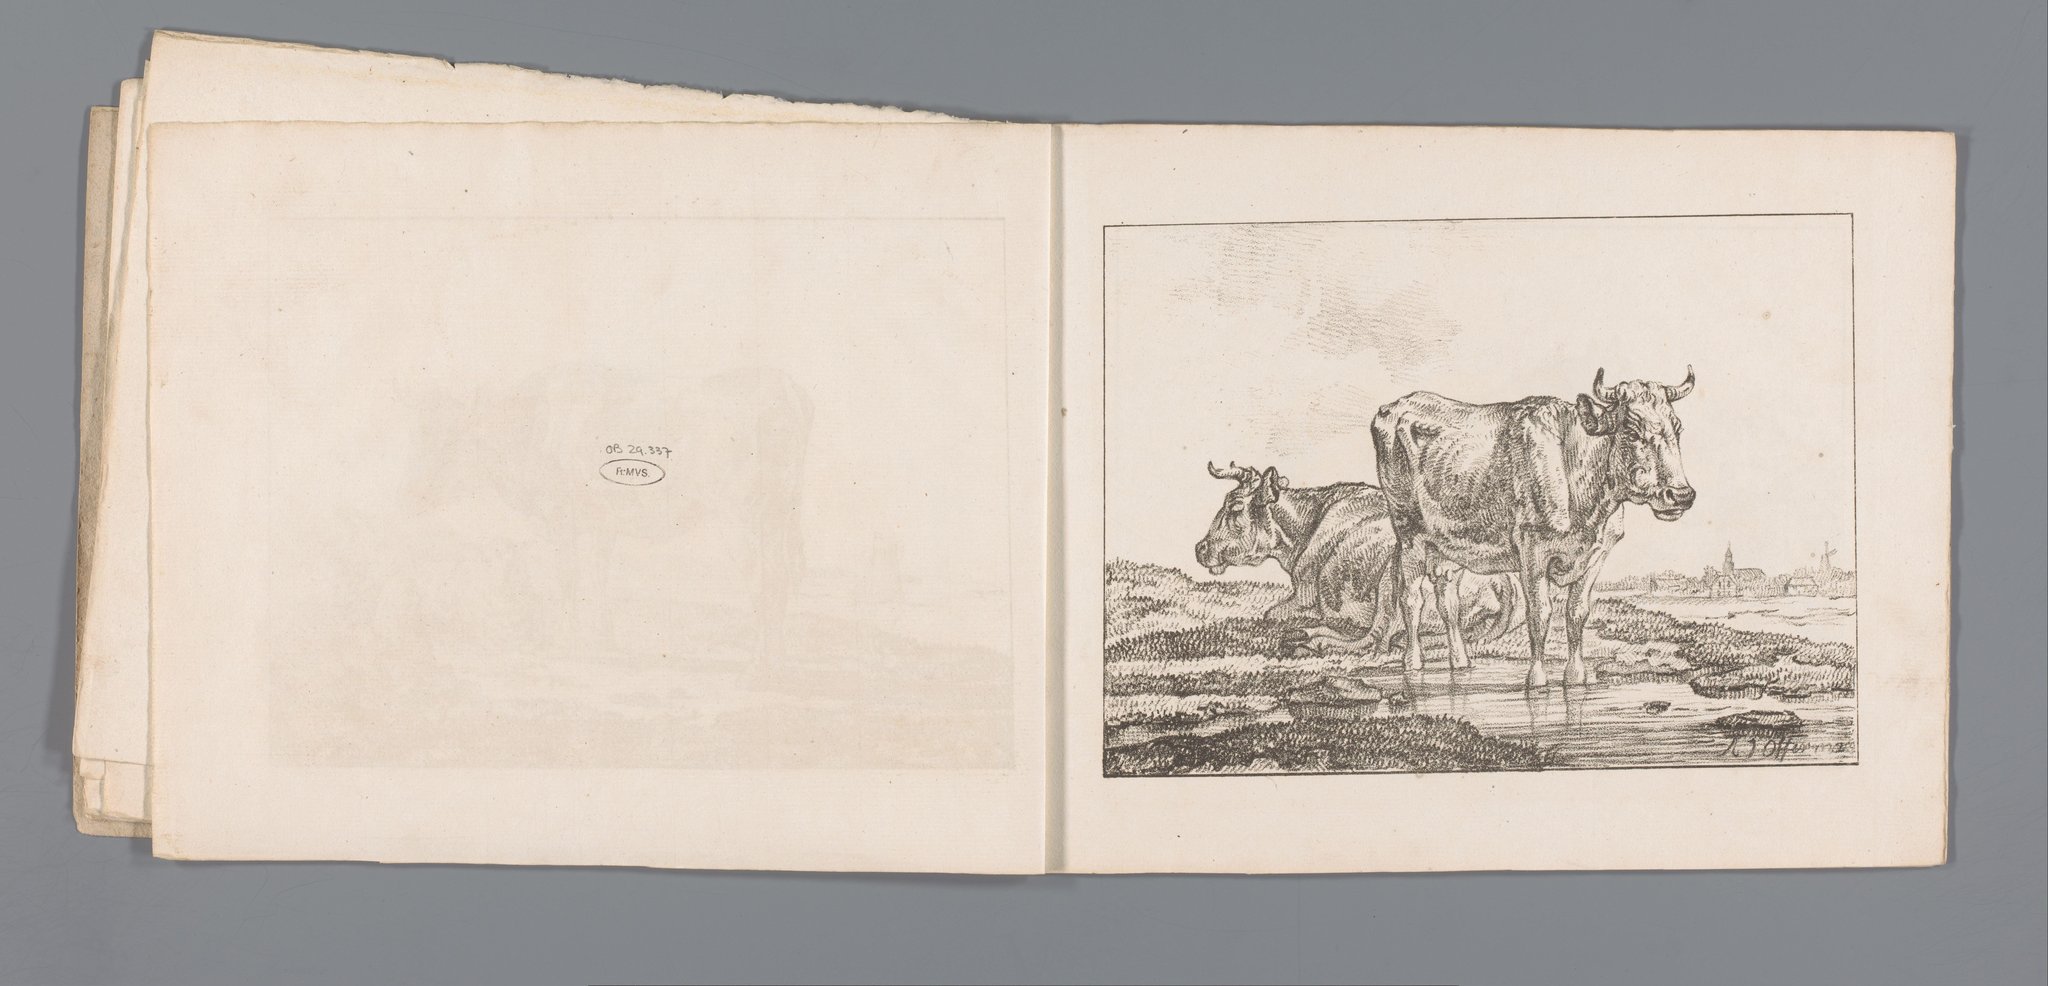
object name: print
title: Twee koeien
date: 1818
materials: paper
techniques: lithograph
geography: rotterdam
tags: cow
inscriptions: collector's mark: Lugt 2228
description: In een wei een liggende koe en een staande koe in een plas. Maakt deel uit van een prentalbum met een serie van acht dierstudies.